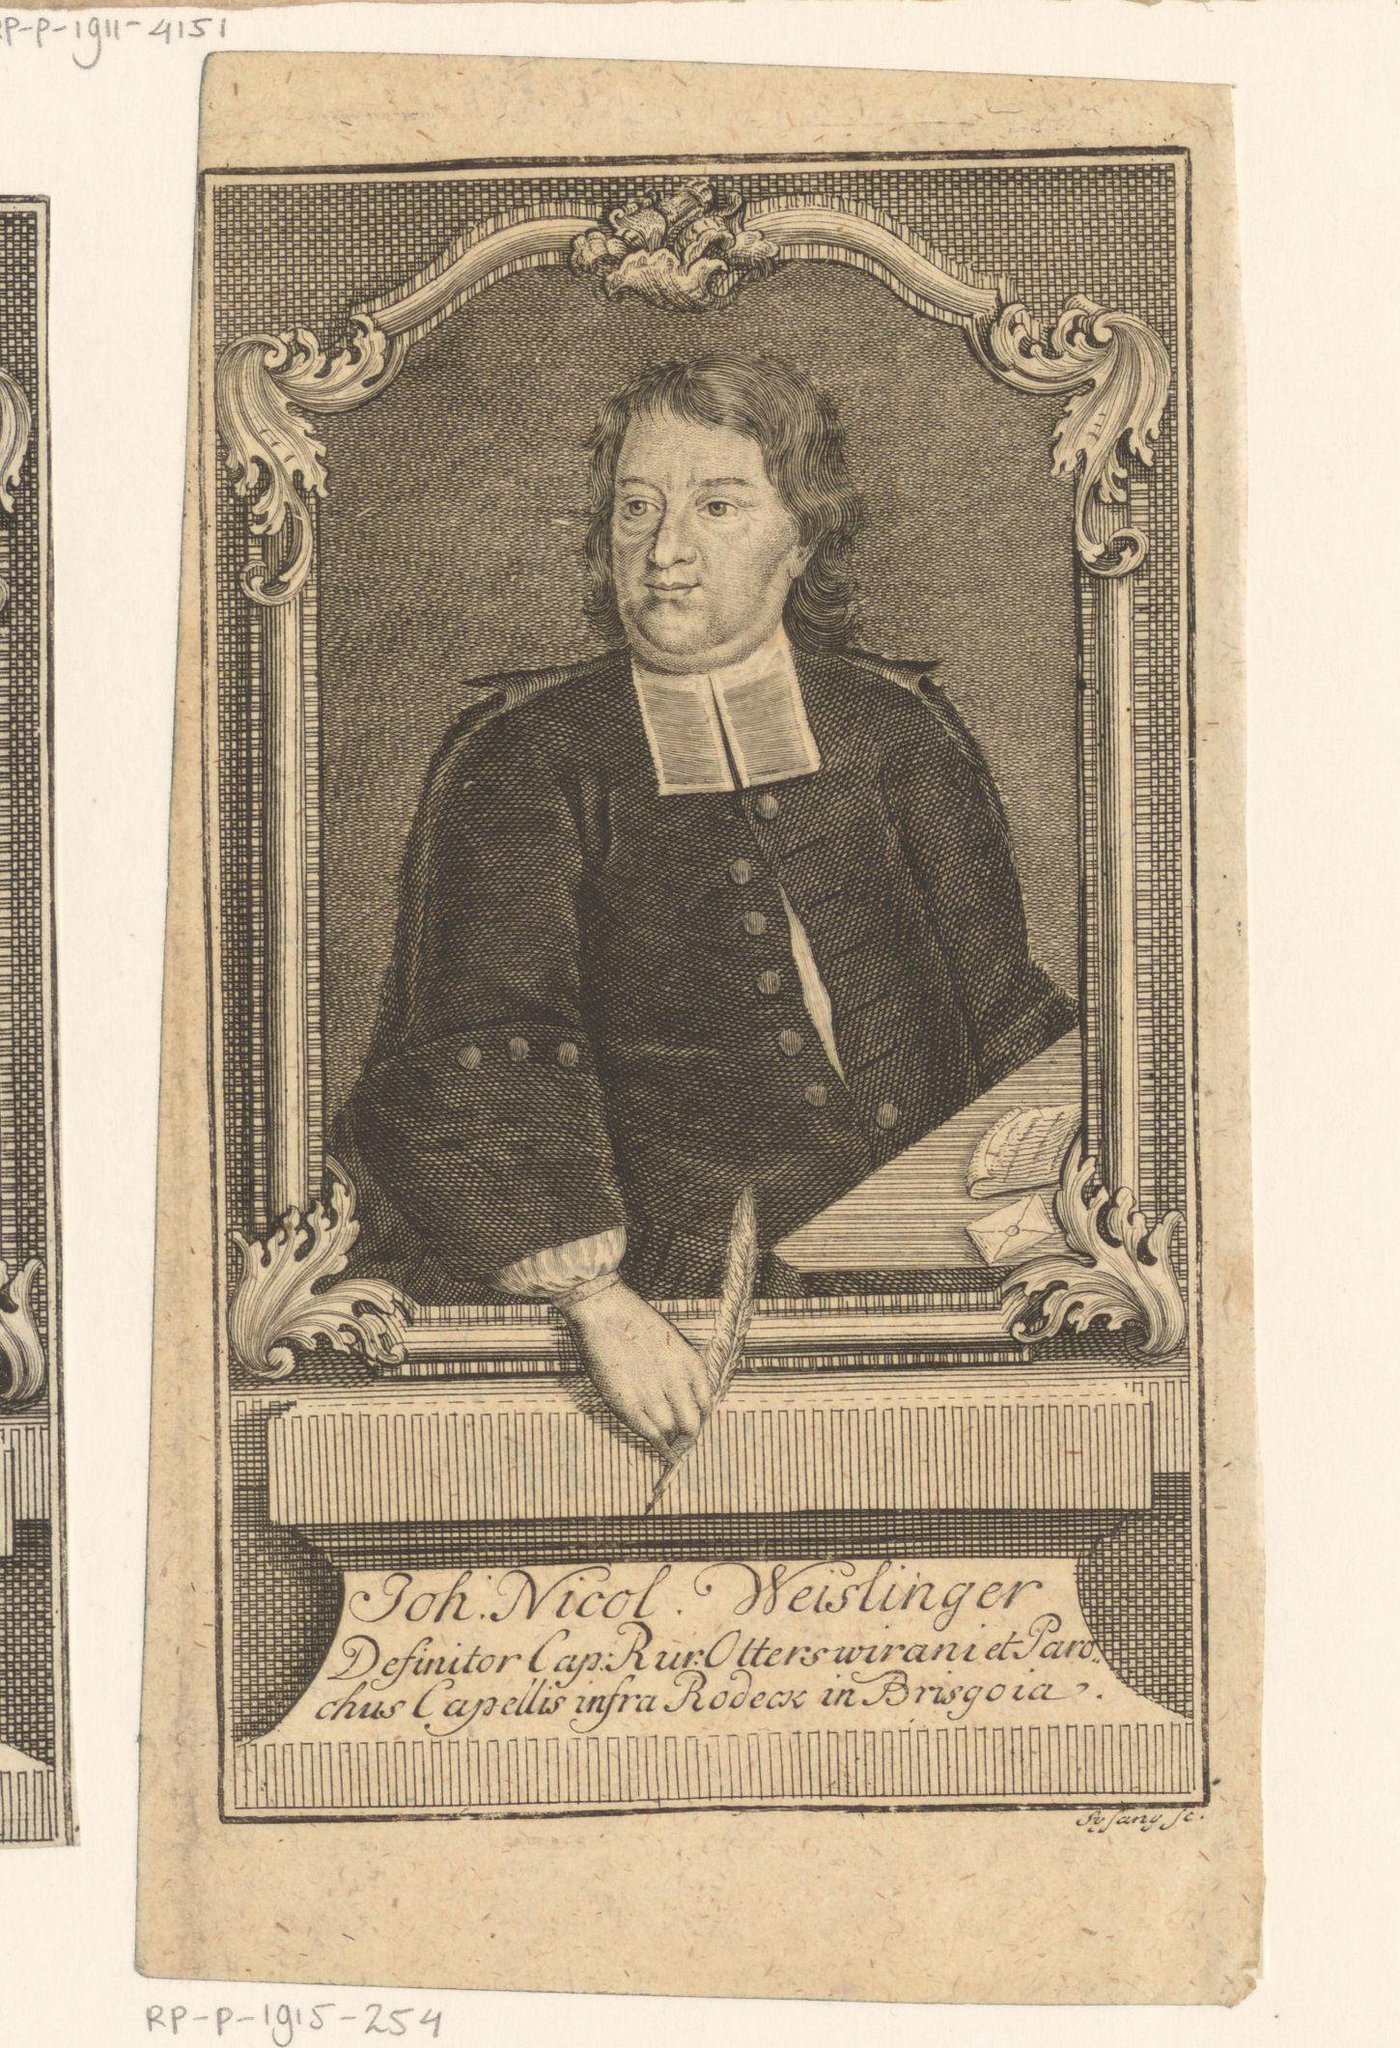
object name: print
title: Portret van Johann Nicolaus Weislinger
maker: johann christoph sysang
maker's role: print maker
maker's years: 1703-1757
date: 1720-1751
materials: paper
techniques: engraving, etching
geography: leipzig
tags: clergyman, writing tools, historical persons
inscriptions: collector's mark: Lugt 2228